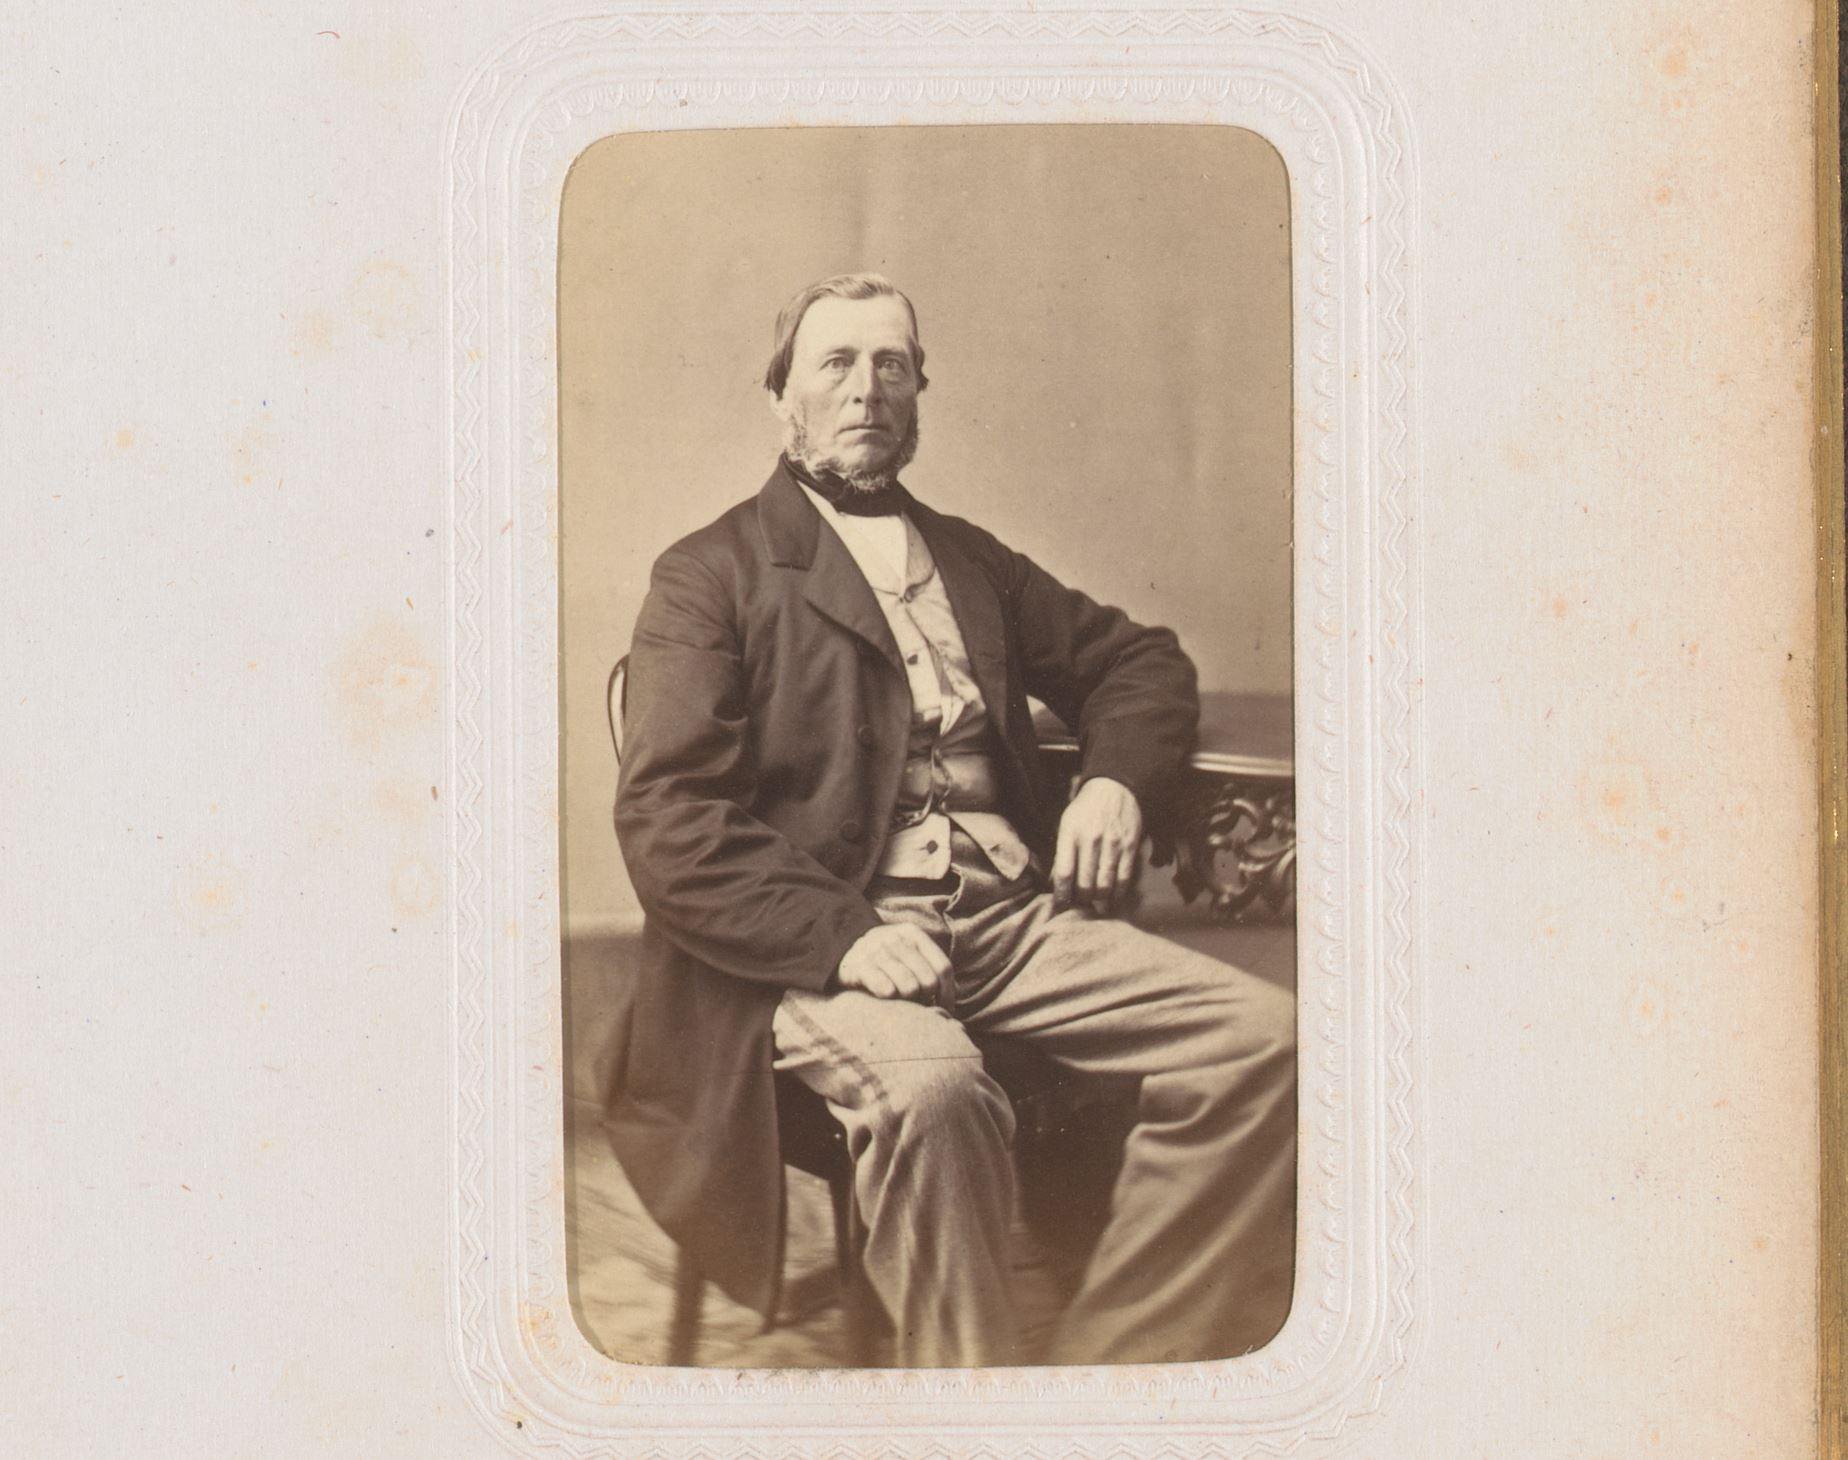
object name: album leaf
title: Portret van een man, zittend aan een tafel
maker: kornelis willem schorteldoek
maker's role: boekbinder, fotograaf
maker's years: 1800-1885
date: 1855-1885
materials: cardboard, photographic support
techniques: albumen print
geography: gorinchem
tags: sitting figure, historical persons, table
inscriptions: inscription: ‘SCHORTELDOEK/ PHOTOGRAAF/ GORINCHEM/ Groote Markt’